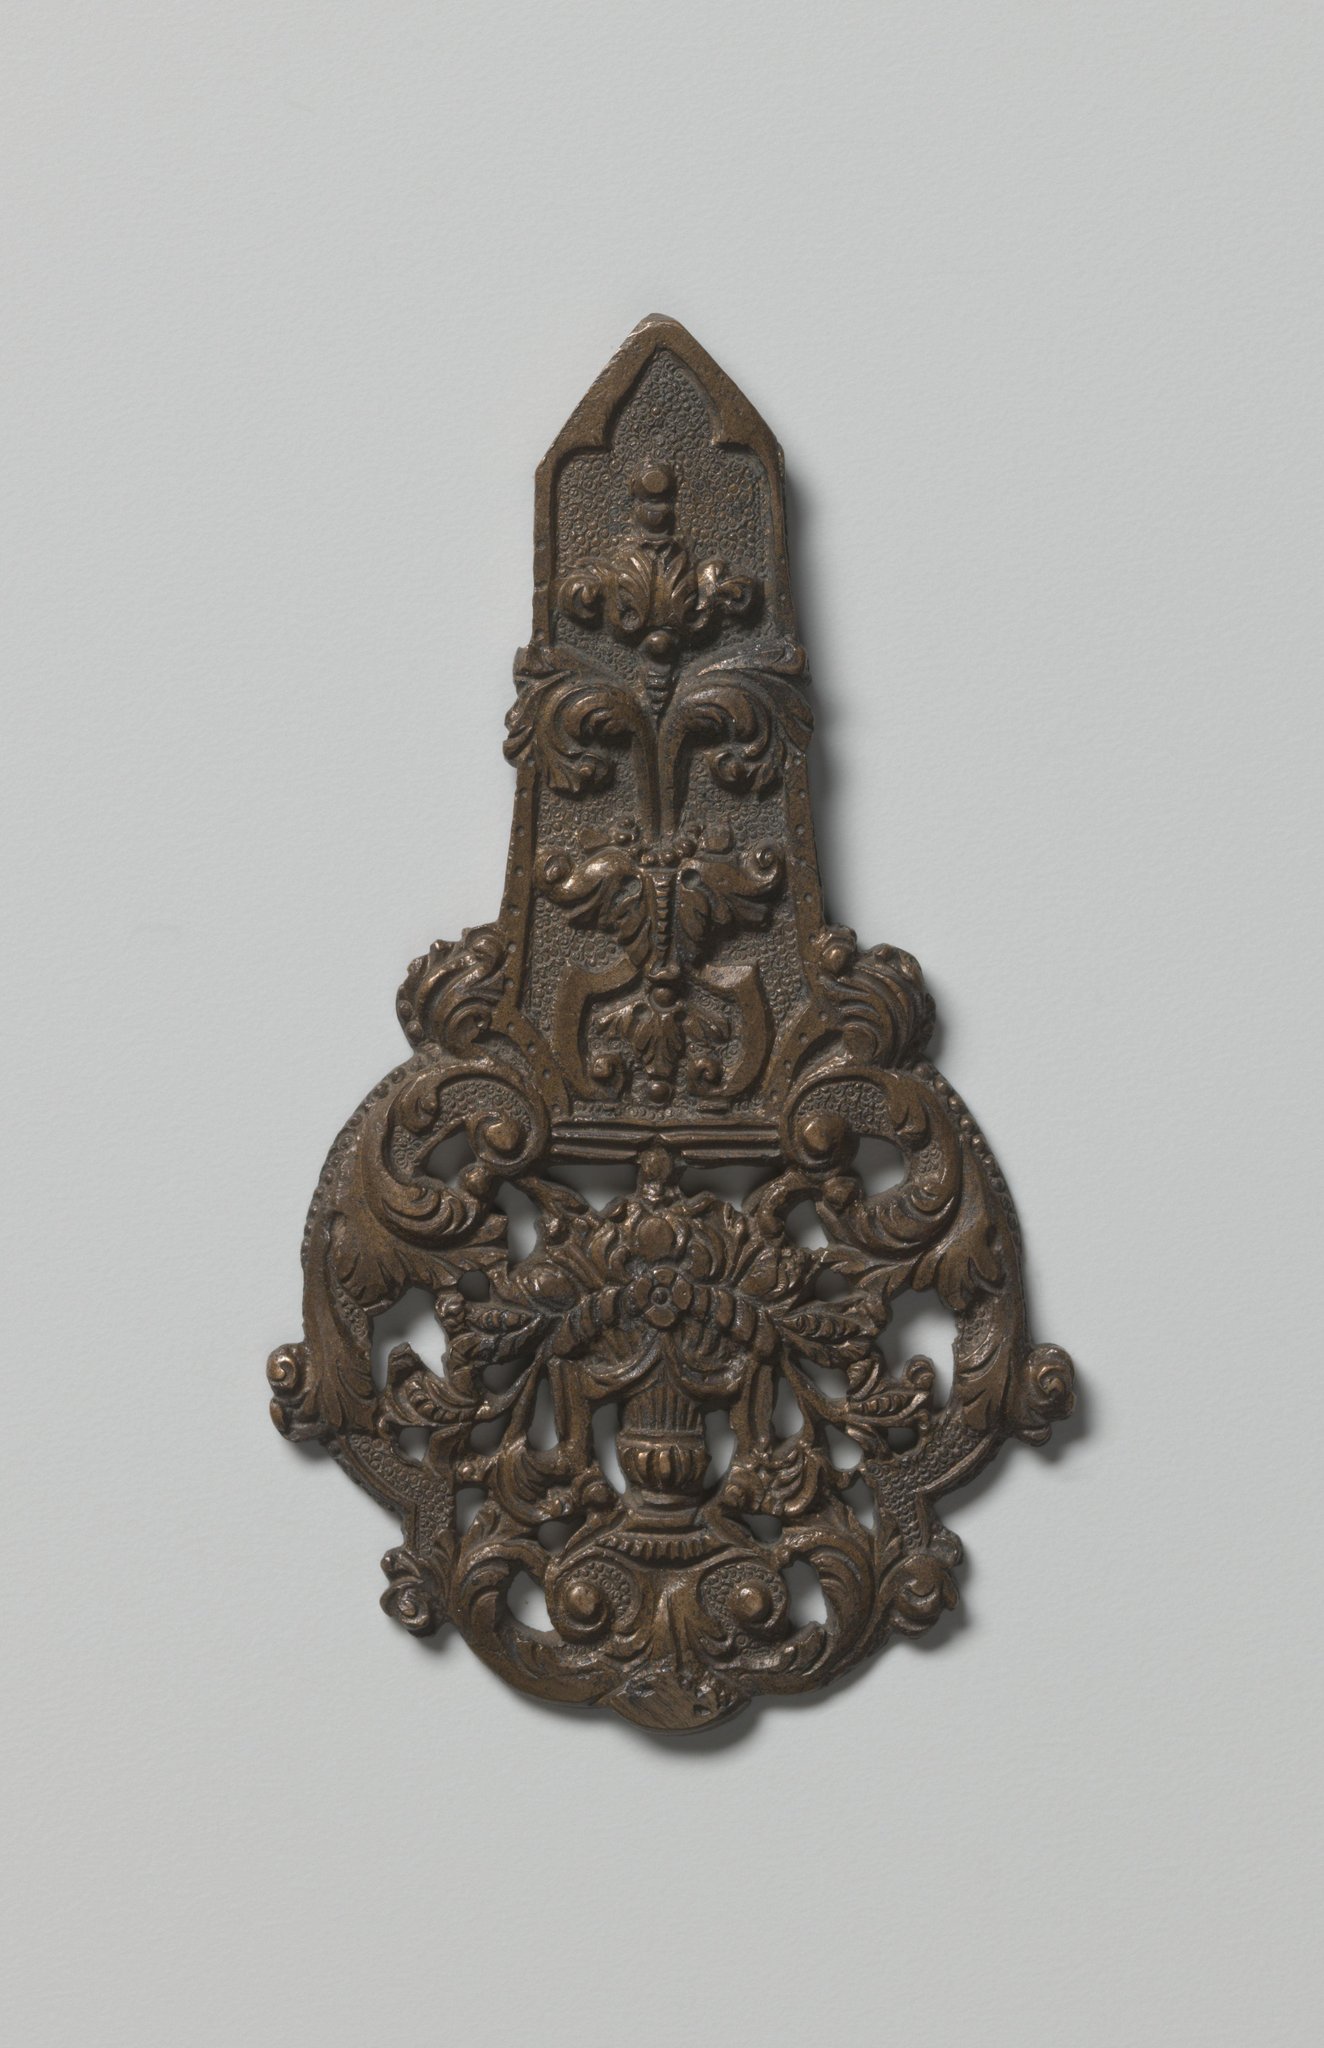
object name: decoration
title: Versieringselement van roodkoper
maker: Anonymous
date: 1700-1710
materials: copper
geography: amsterdam